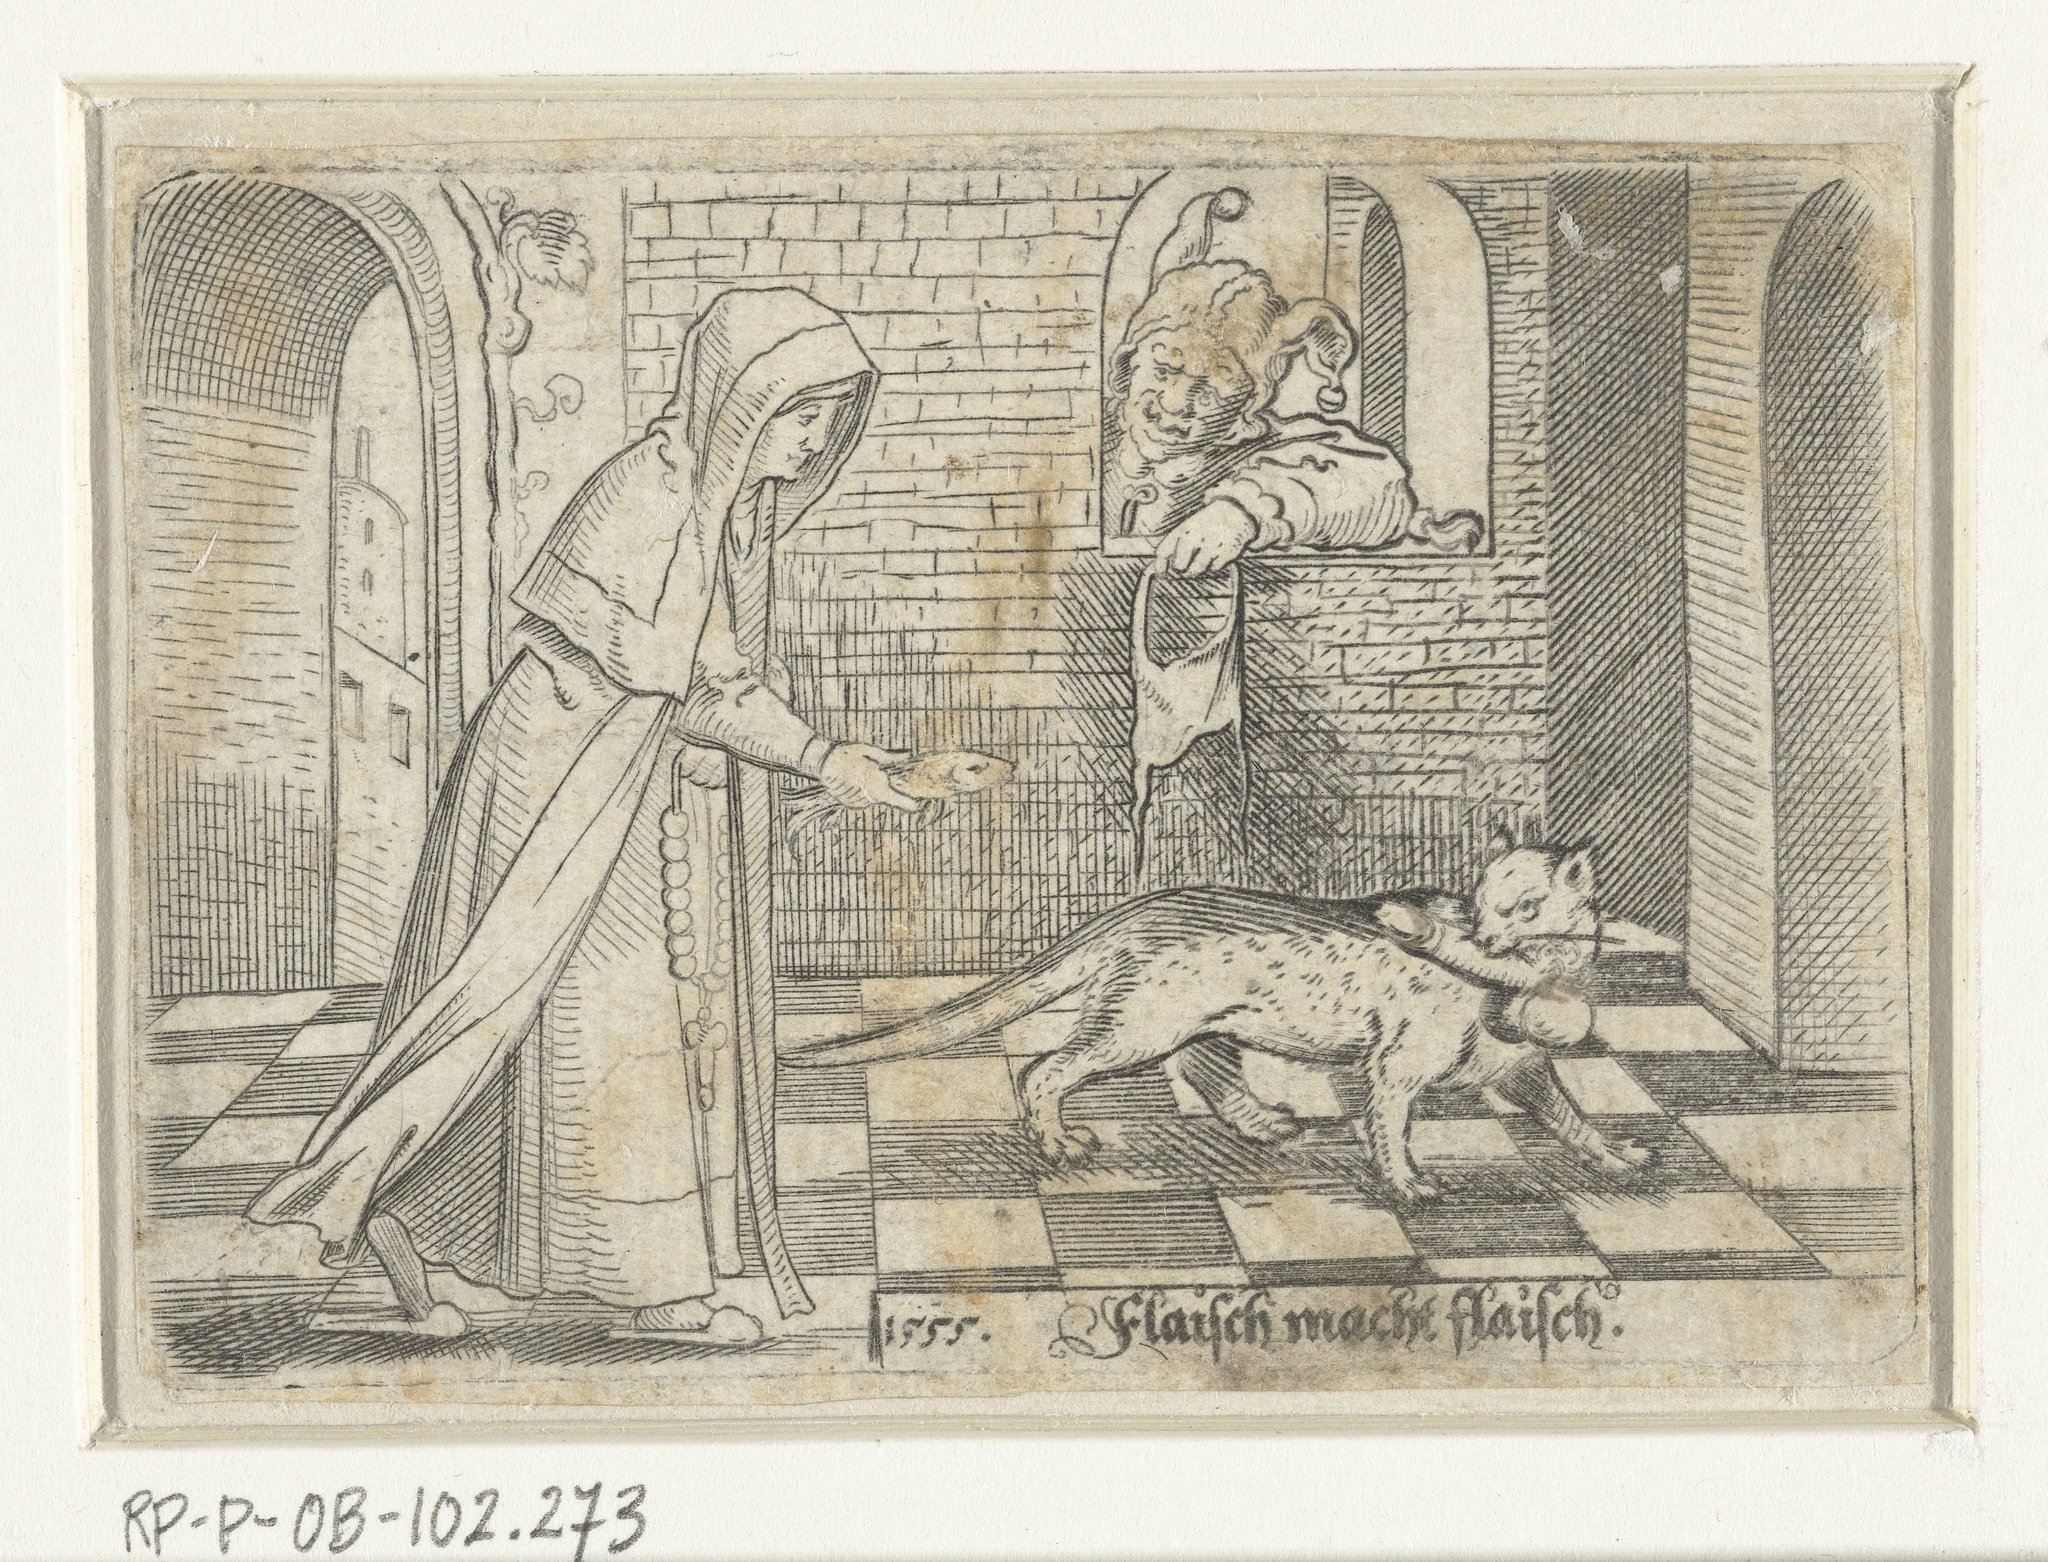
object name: print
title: Flaisch macht Flaisch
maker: Anonymous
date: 1555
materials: paper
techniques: engraving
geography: germany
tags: cat, fool, simpleton, numskull, nun(s)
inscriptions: date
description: Een non loopt met een vis in de hand een kat achterna, in haar handen een rozenkrans met een phallus. De non wil de vis ruilen met de penis die de kat in de bek heeft. Een nar kijkt toe door een raamkozijn.